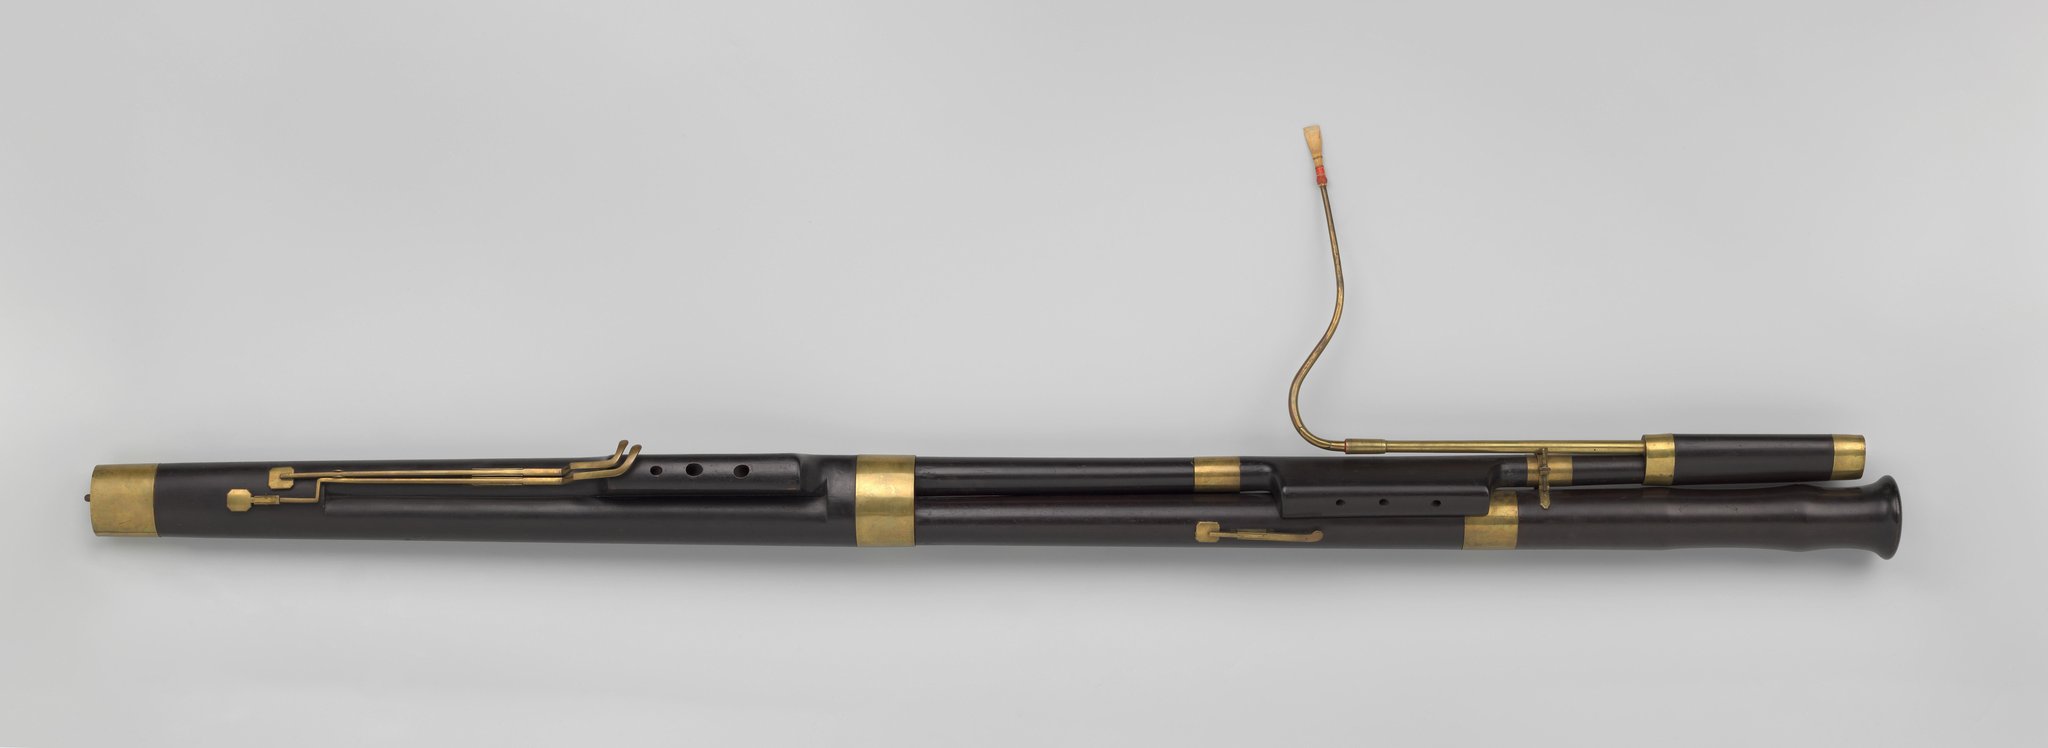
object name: double bassoon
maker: Anonymous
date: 1810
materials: brass, wood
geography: vienna state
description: The contrabassoon has a windway that is double the length of the standard bassoon’s, and it plays an octave lower. Between the late 18th century and early 19th century, contrabassoon makers were mostly active in the Habsburg Empire, especially in Vienna. Early contrabassoons, such as this exquisite exemplar, are very rare.